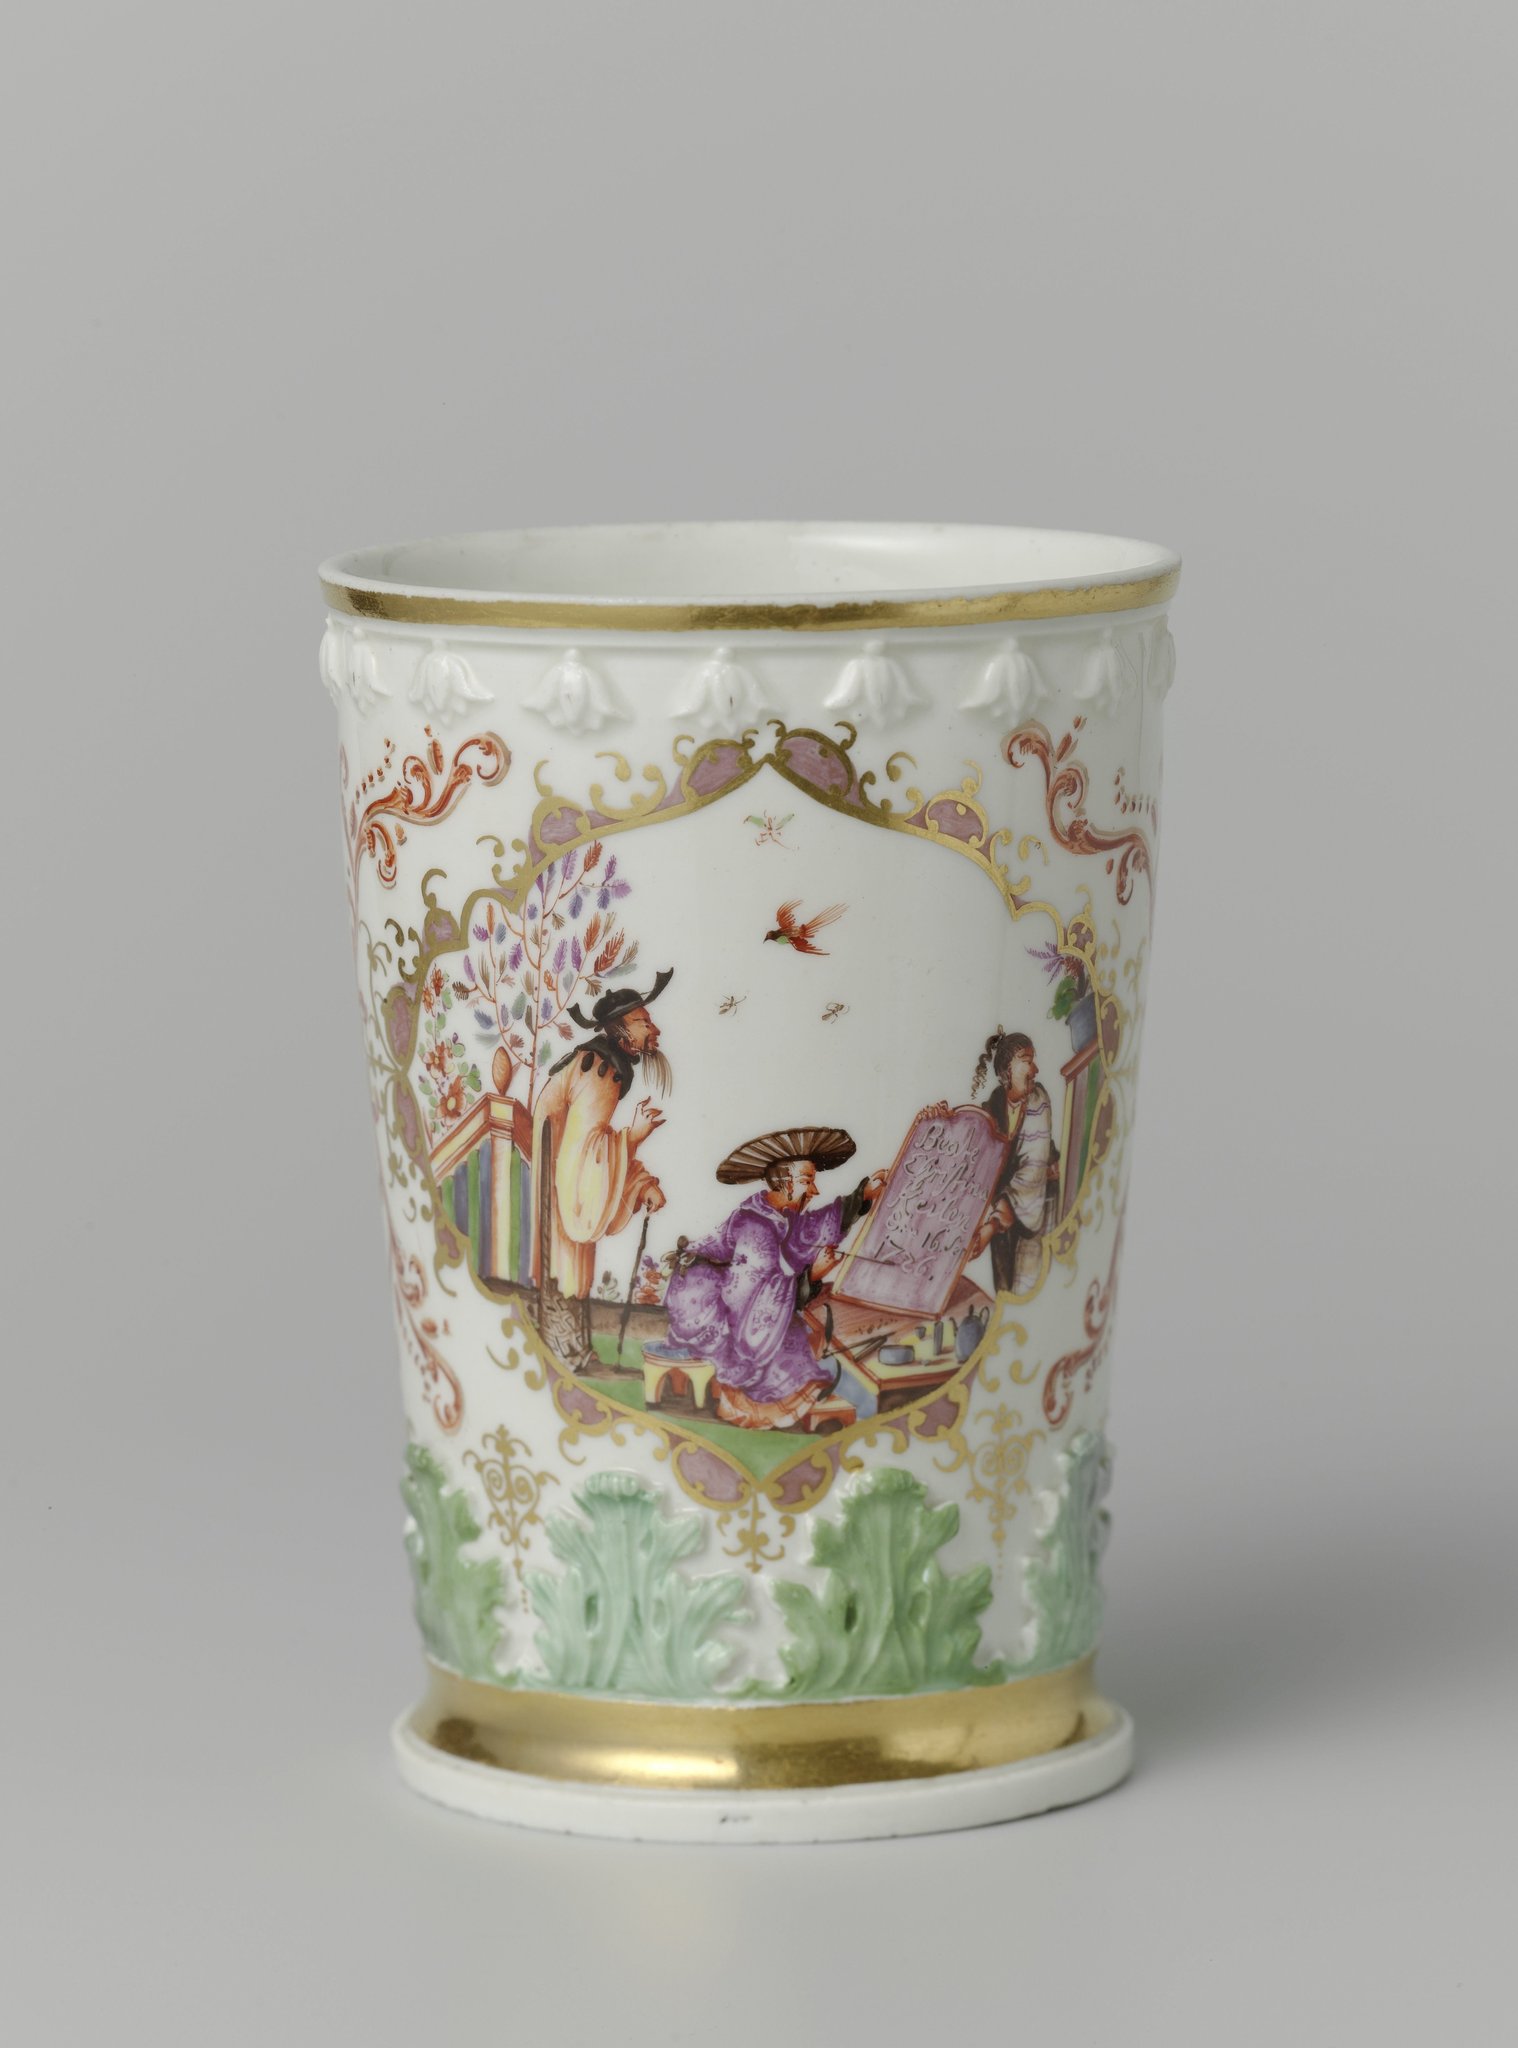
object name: eating drinking utensil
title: Beker, veelkleurig beschilderd met chinoiserieën in een vierpas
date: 1726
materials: porcelain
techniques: painted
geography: meissen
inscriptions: label: ‘SAMMLUNG / Dr. FRANZ OPPENHEIMER’, number: ‘13’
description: Beaker. Porcelain. Meissen, 16 September 1726, probably decorated by Johann Gregorius Höroldt. This beaker was a personal gift to Höroldt's mother-in-law Beate Christin.